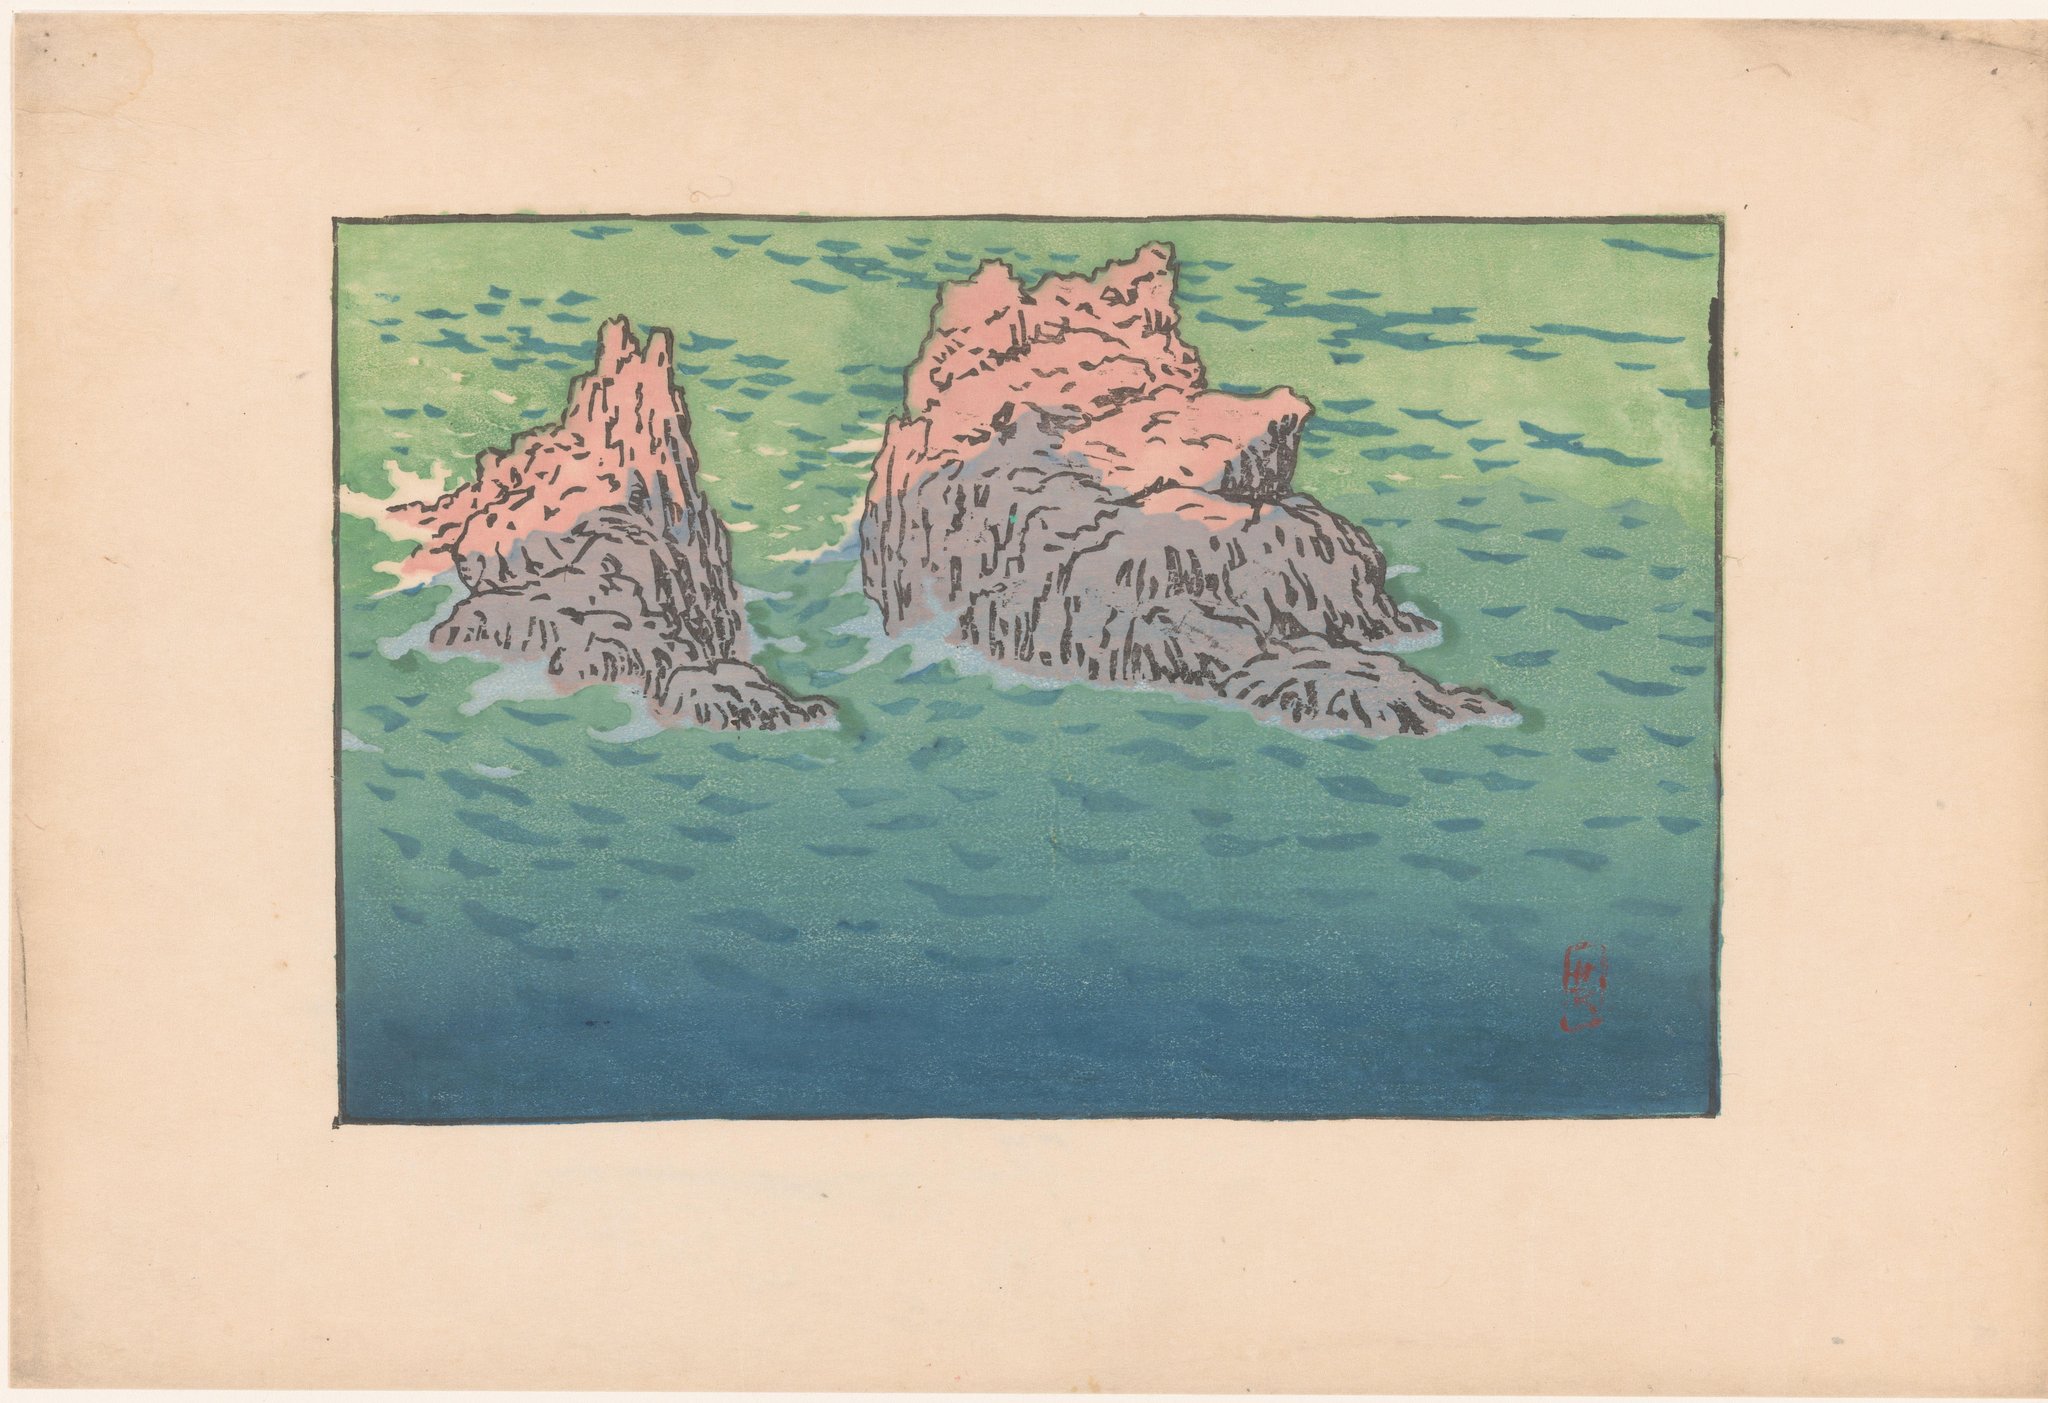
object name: print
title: Rotsen in water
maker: henri rivière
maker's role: draughtsman, print maker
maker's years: 1864-1951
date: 1874-1951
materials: paper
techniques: woodcut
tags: rocky coast, rocks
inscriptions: stamp: Lugt 1362, collector's mark: Lugt 2760